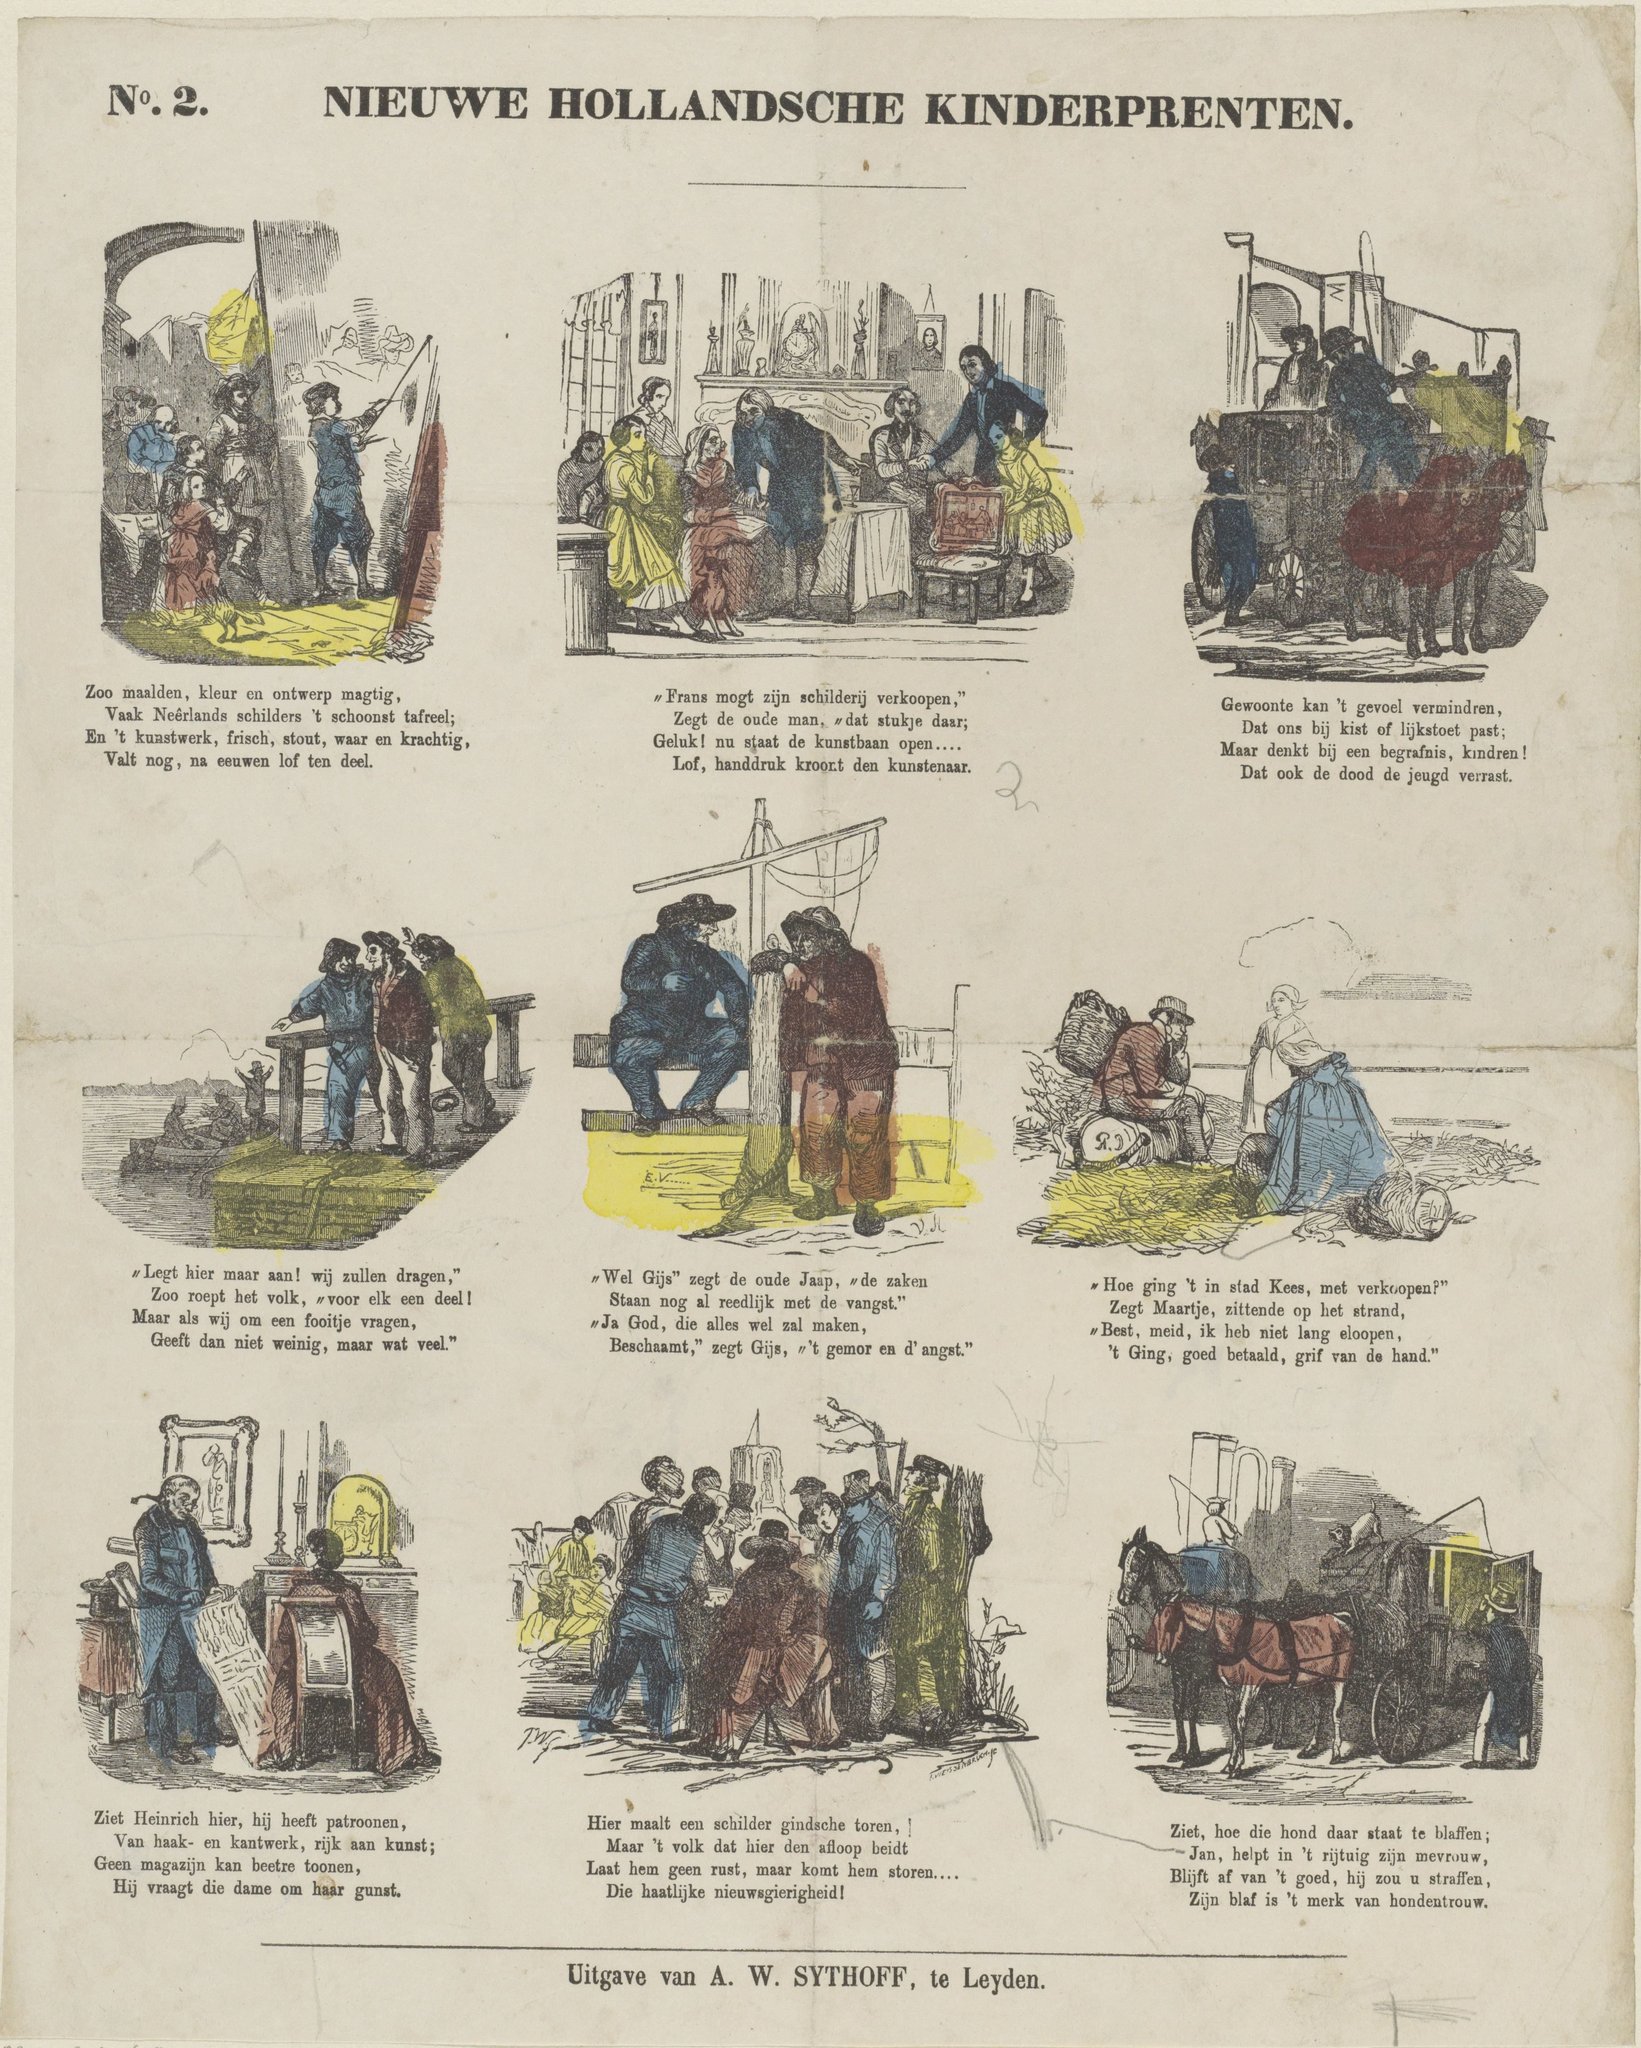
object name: popular print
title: Zoo maalden, kleur en ontwerp magtig [(...)]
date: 1861-1929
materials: paper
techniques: colour, letterpress printing, engraving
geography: europe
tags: human types, four-wheeled, animal-drawn vehicle, e.g.: cab, carriage, coach, characters (human types), painter at work, in his studio - cc - out of doors, fisherman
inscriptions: collector's mark: Lugt 2760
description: Blad met 9 voorstellingen van verschillende aard, zoals voorstellingen van een schilder aan het werk, van vissers en van een rijtuig. Onder elke voorstelling een vierregelig vers. Genummerd linksboven: No. 2.